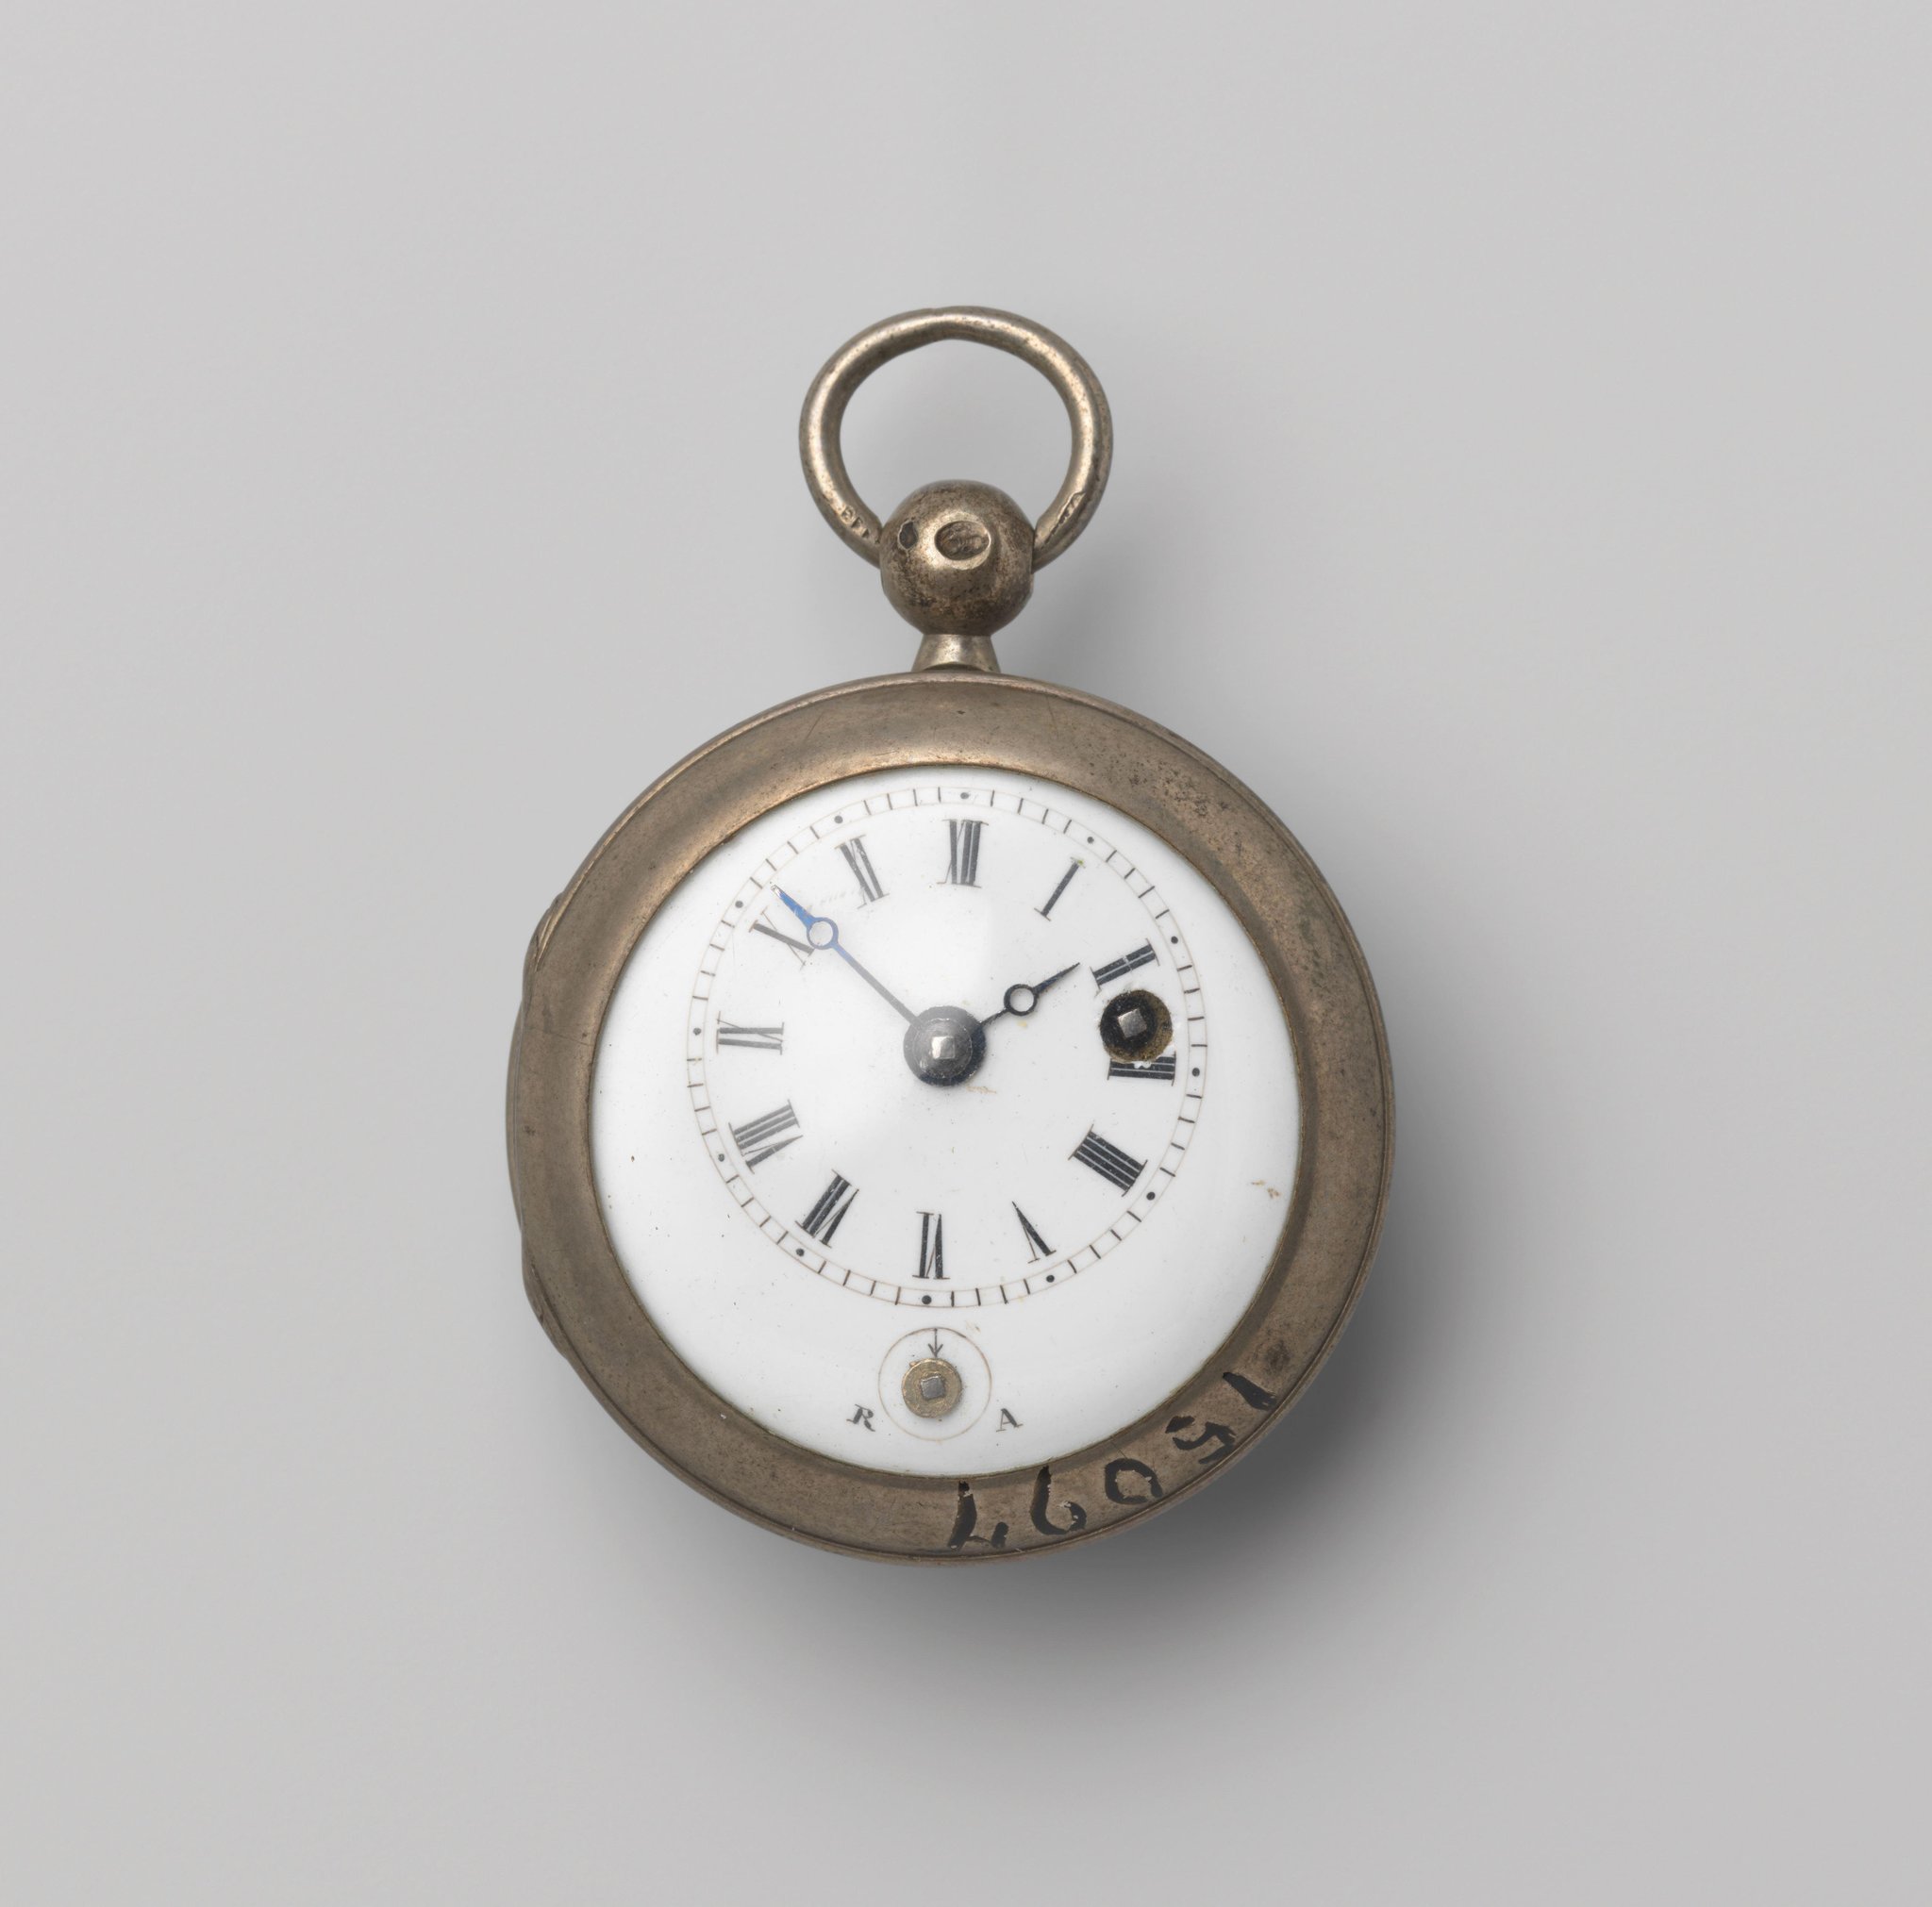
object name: wrist watch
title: Horloge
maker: Anonymous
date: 1840-1860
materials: silver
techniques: enameling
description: Herenhorloge van zilver met twee wit geëmailleerde wijzerplaten. Eén met Romeinse uurcijfers, de andere, met de kalenderaanwijzing, is voorzien van namen van de week in het Frans en de data in Arabische cijfers.